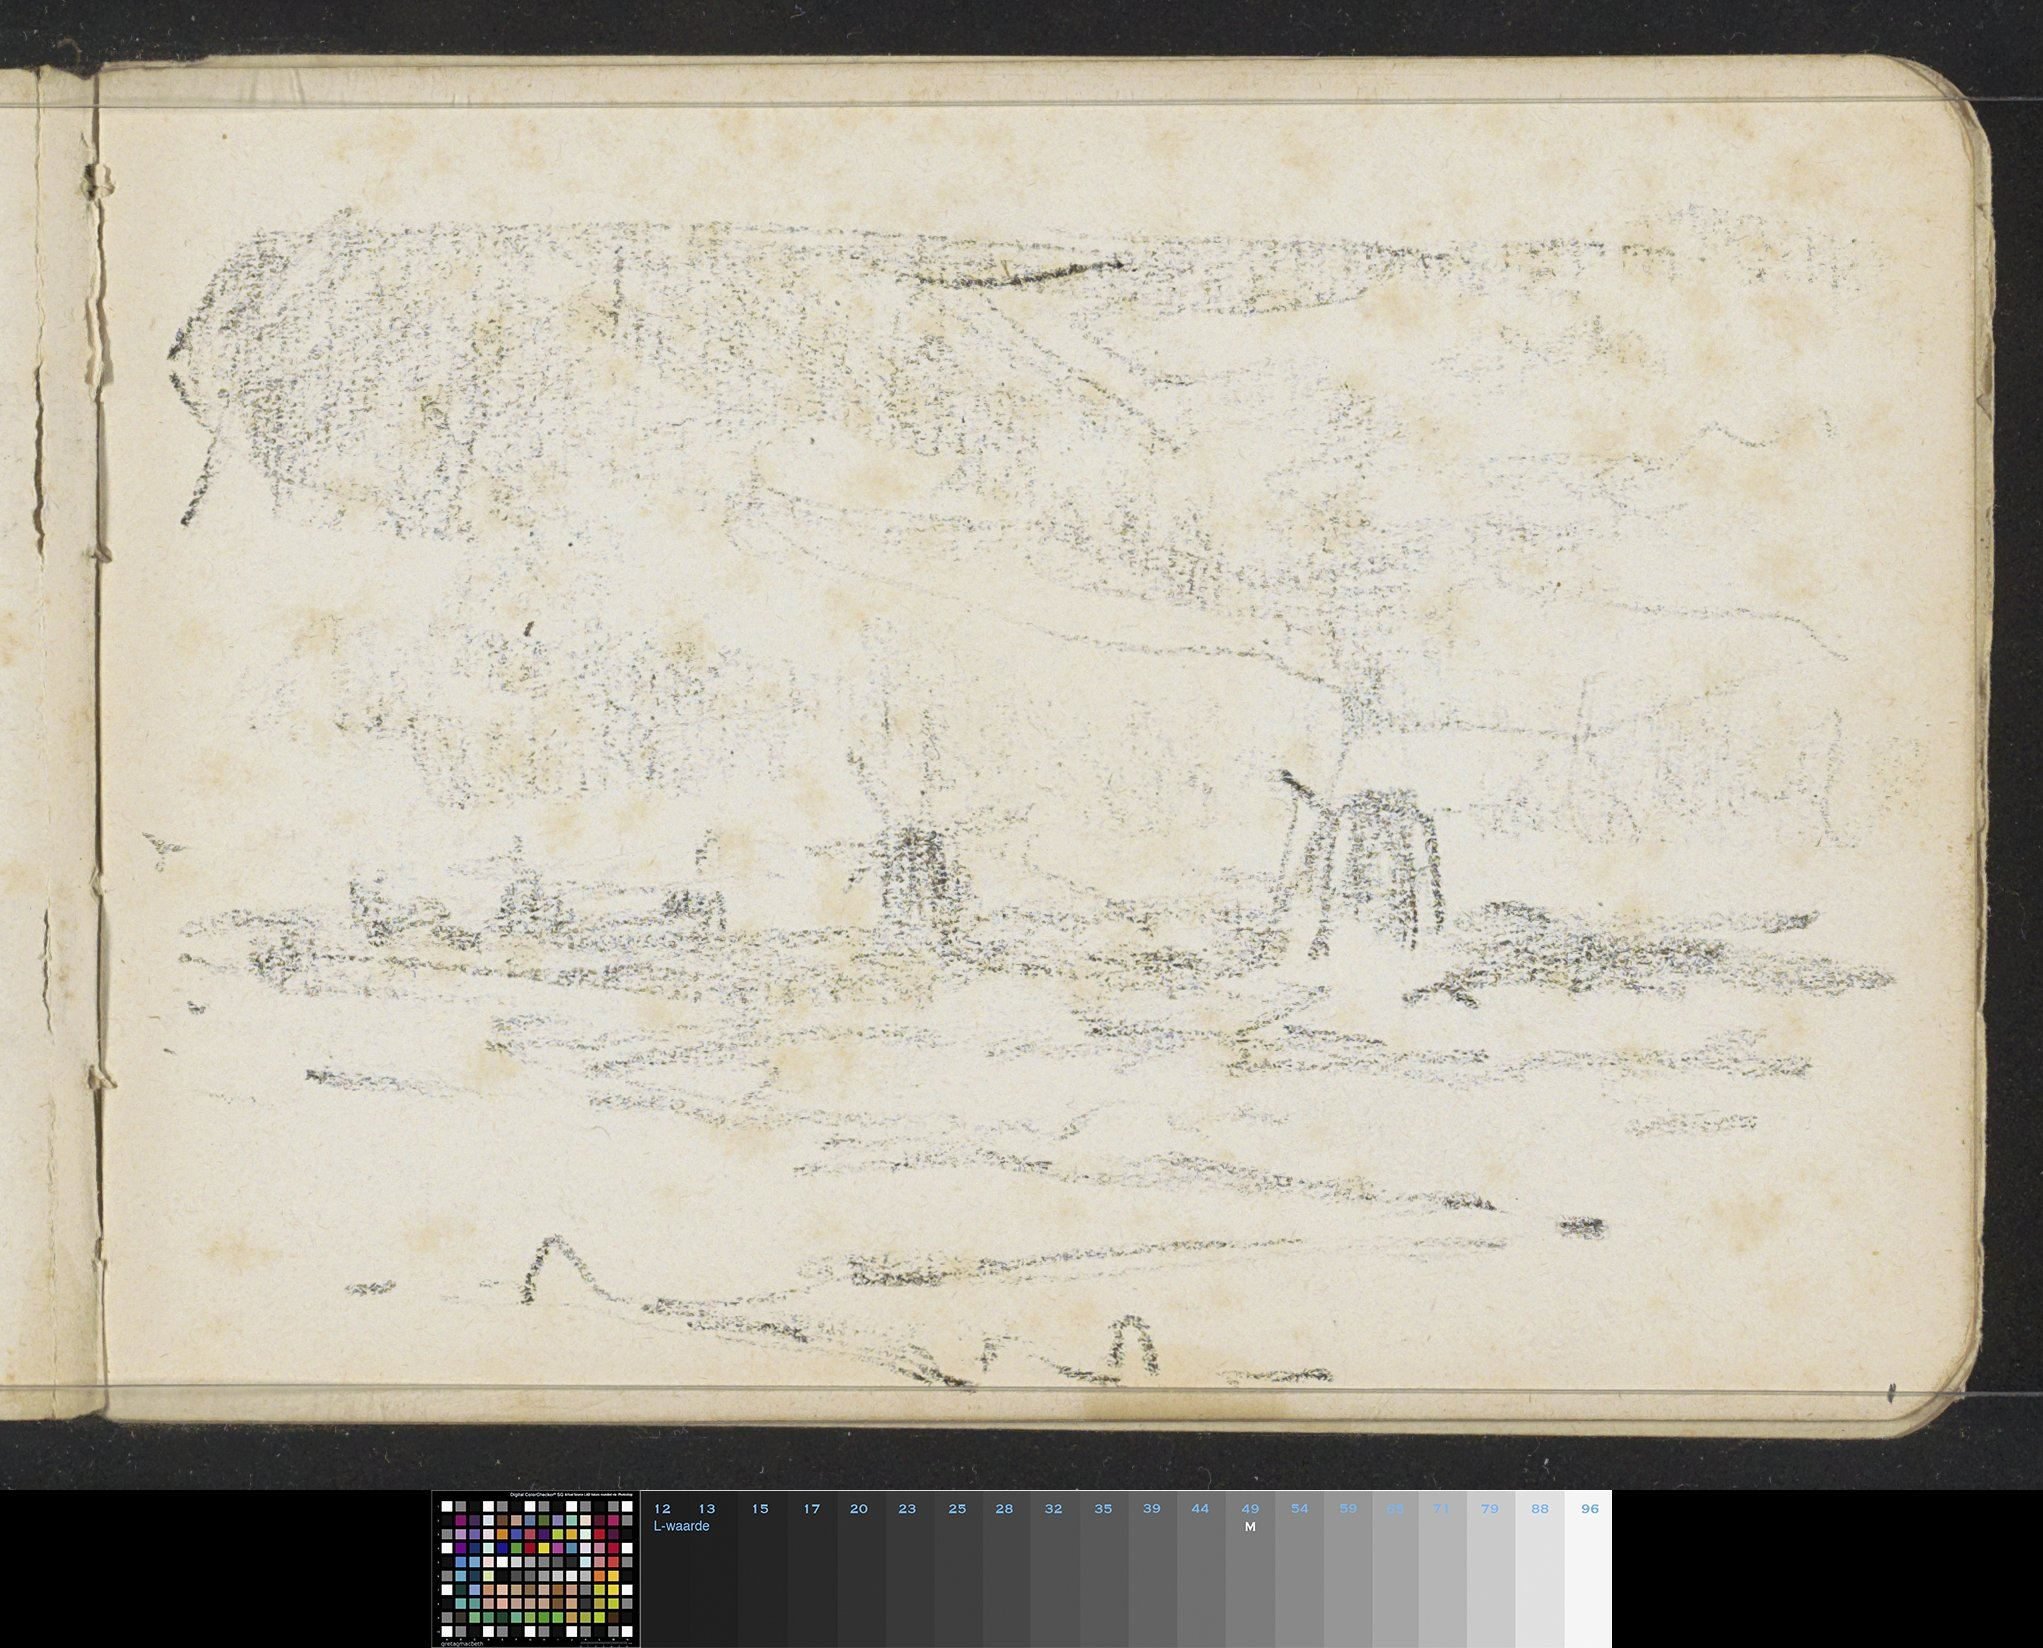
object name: sketchbook leaf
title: Landschap met molens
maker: willem cornelis rip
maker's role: draughtsman, painter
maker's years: 1856-1922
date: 1866-1922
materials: chalk, paper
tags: windmill in landscape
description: Blad 1 recto uit een schetsboek met 44 bladen.